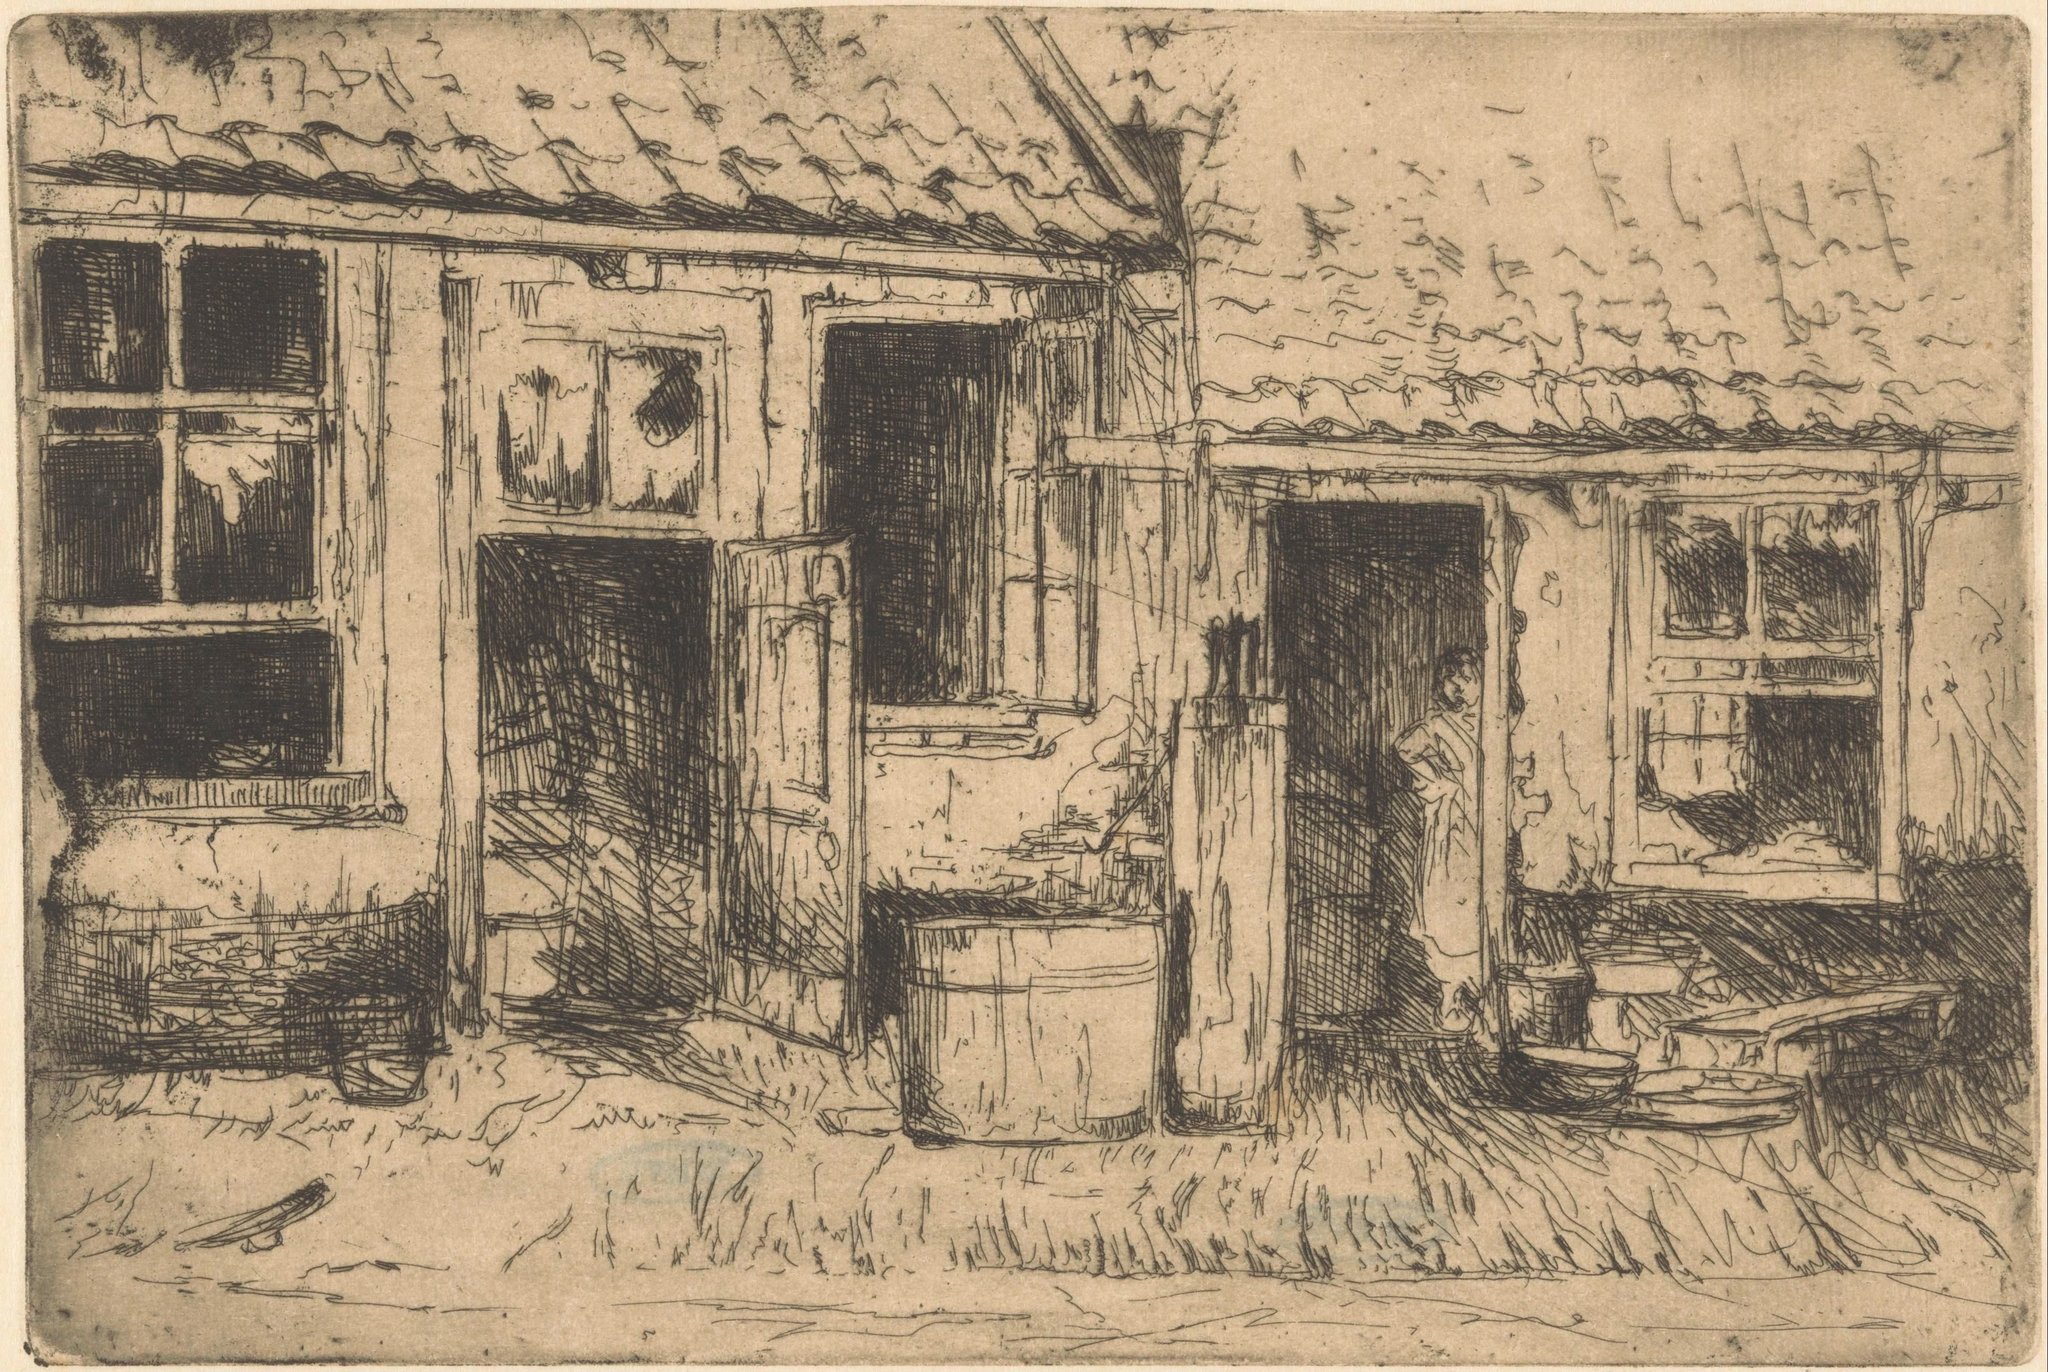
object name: print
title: Boerderij bij Voorburg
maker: willem adrianus grondhout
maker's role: draughtsman, painter, print maker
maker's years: 1878-1934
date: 1888-1934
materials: paper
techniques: etching, intaglio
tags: pump, farm (building), voorburg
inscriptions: collector's mark: Lugt 2228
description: Voor de boerderij een waterpomp. In de deuropening een staande vrouw.